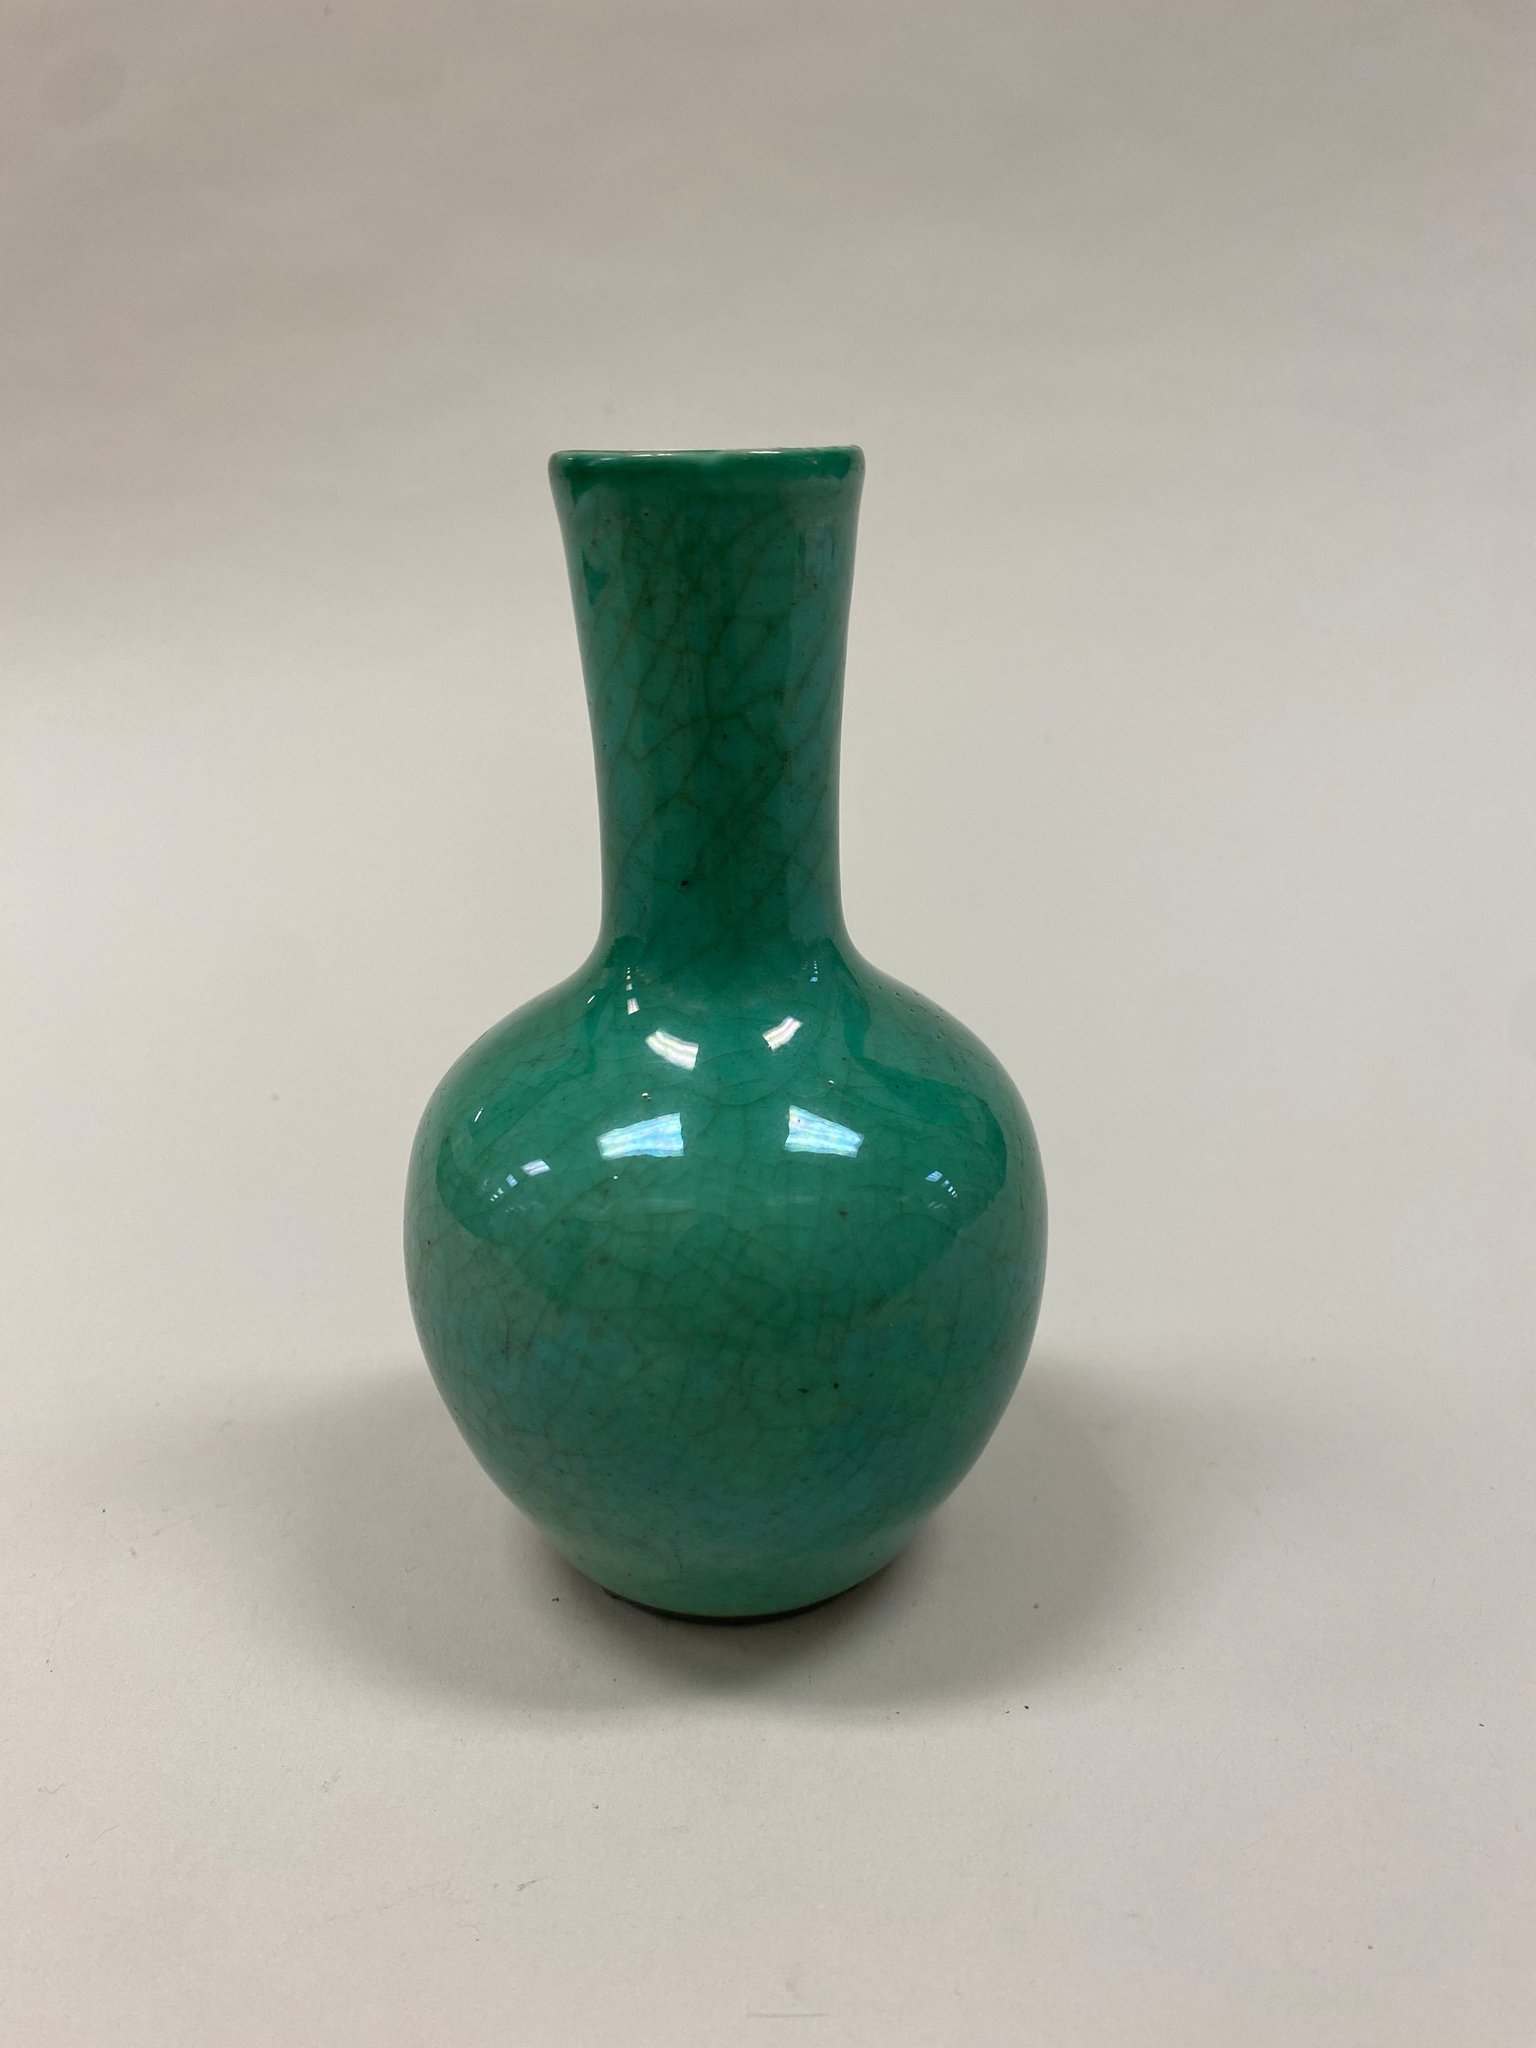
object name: bottle vase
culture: chinese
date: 1701-1800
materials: glaze, porcelain